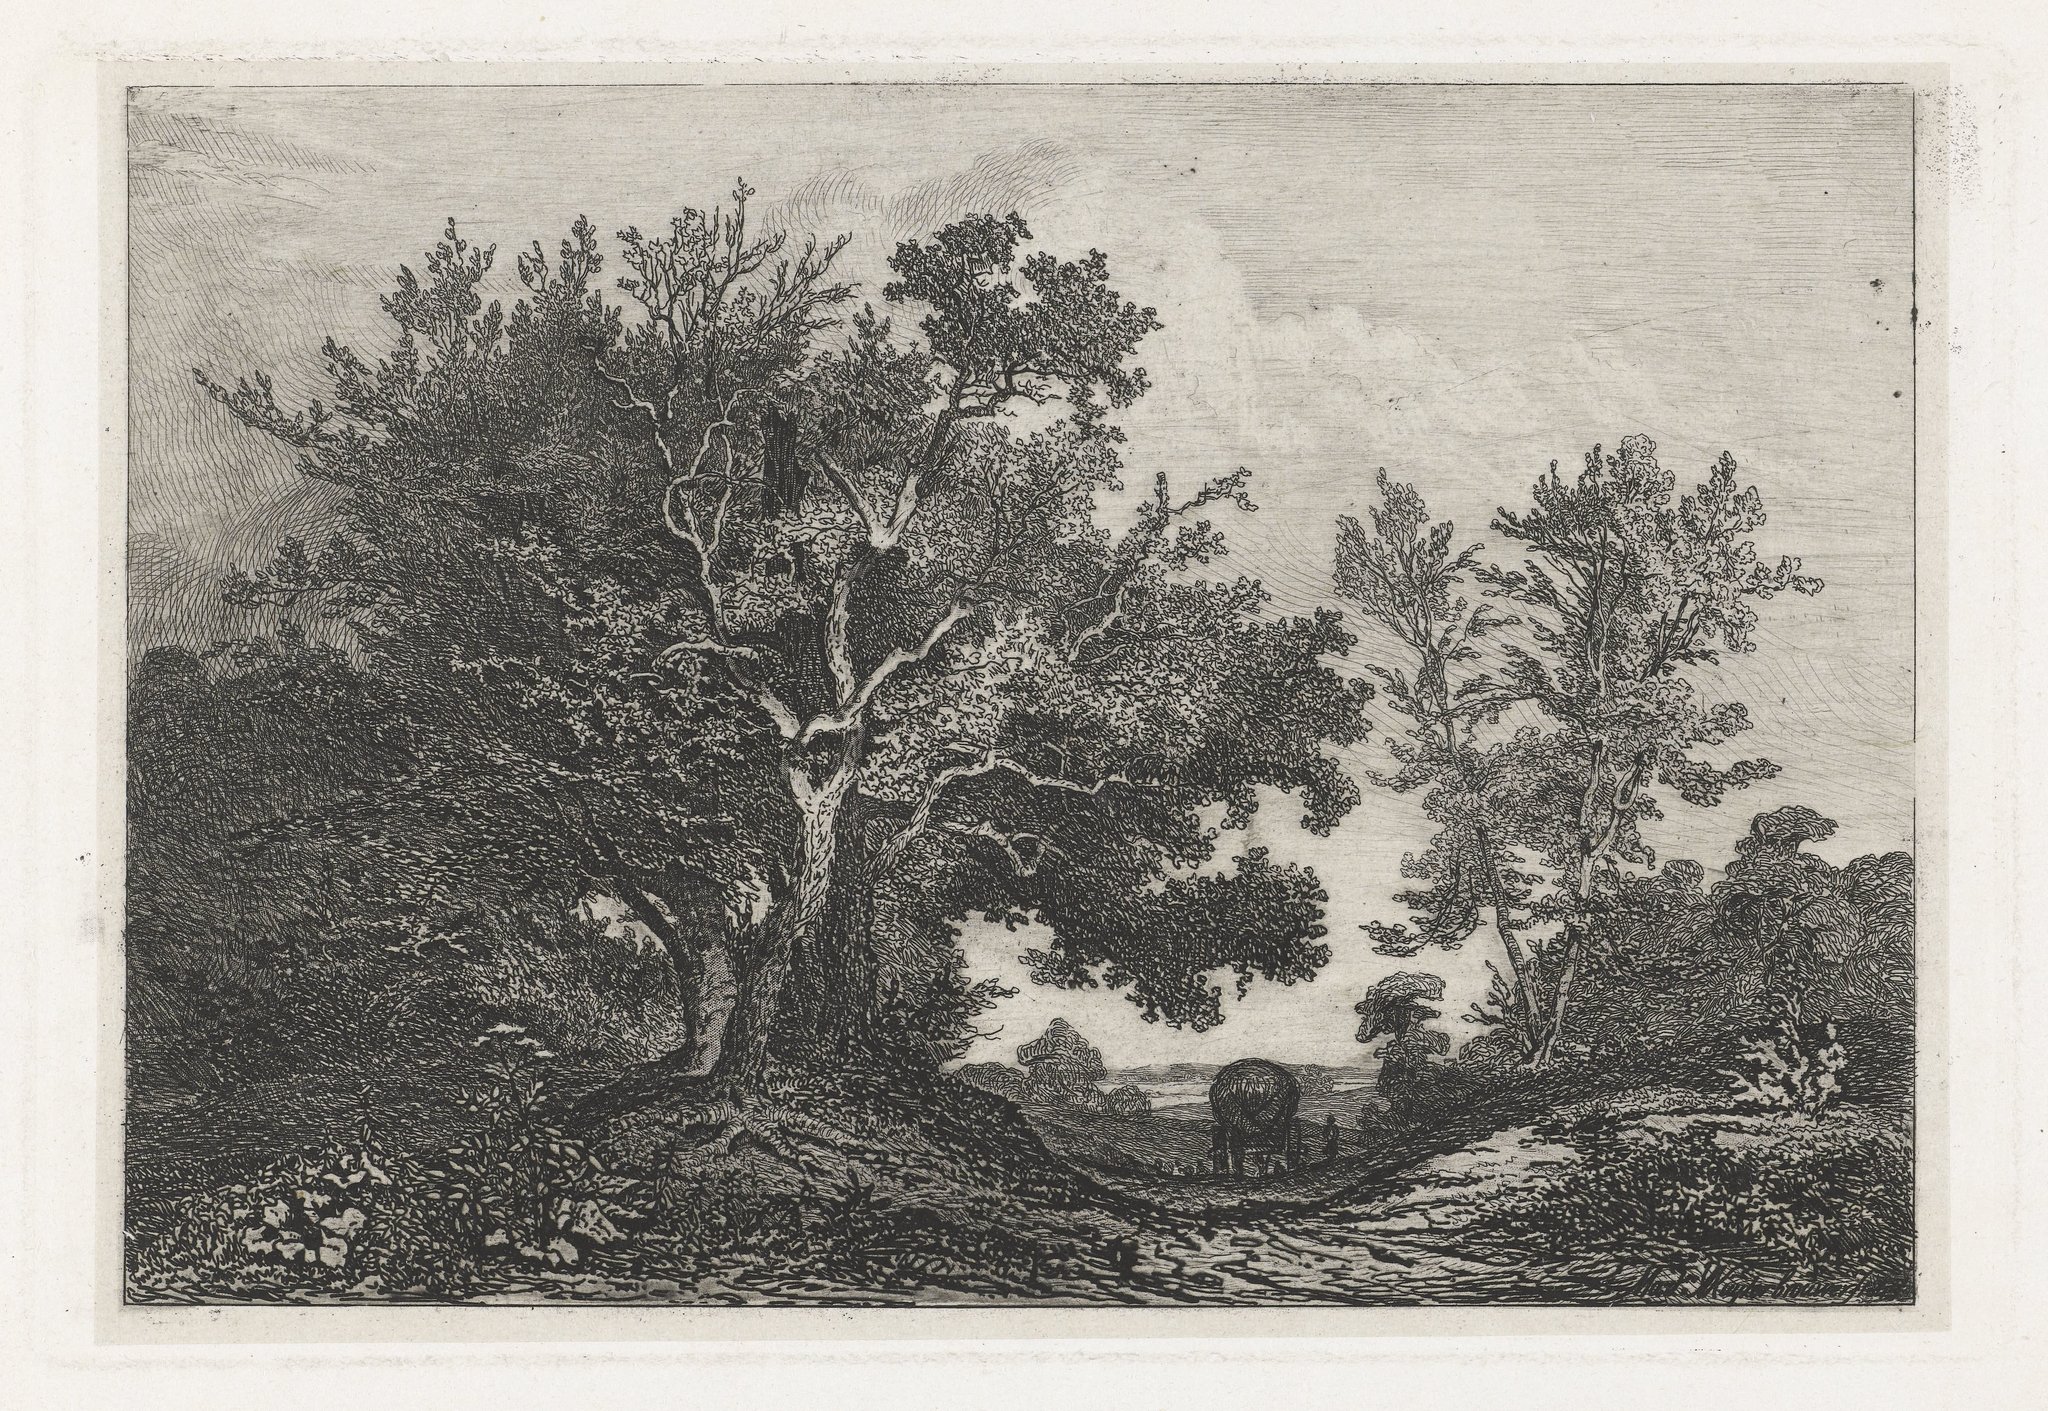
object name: print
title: Landweg tussen de twee boompartijen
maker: martinus antonius kuytenbrouwer jr.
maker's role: draughtsman, painter, print maker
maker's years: 1821-1897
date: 1845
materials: paper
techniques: drypoint, etching, intaglio, roulette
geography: the hague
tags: trees, landscapes, herding, herdsman, herdswoman, shepherd, shepherdess, cowherd, etc., sheep, hay-wagon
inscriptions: collector's mark: Lugt 2228, collector's mark: Lugt 2760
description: Gezicht op een heuvelachtig landschap met een weg tussen twee boomgroepen. Op de weg, onder de takken van de grote boom links, rijdt een hooiwagen en bevindt zich een herder met zijn kudde schapen.